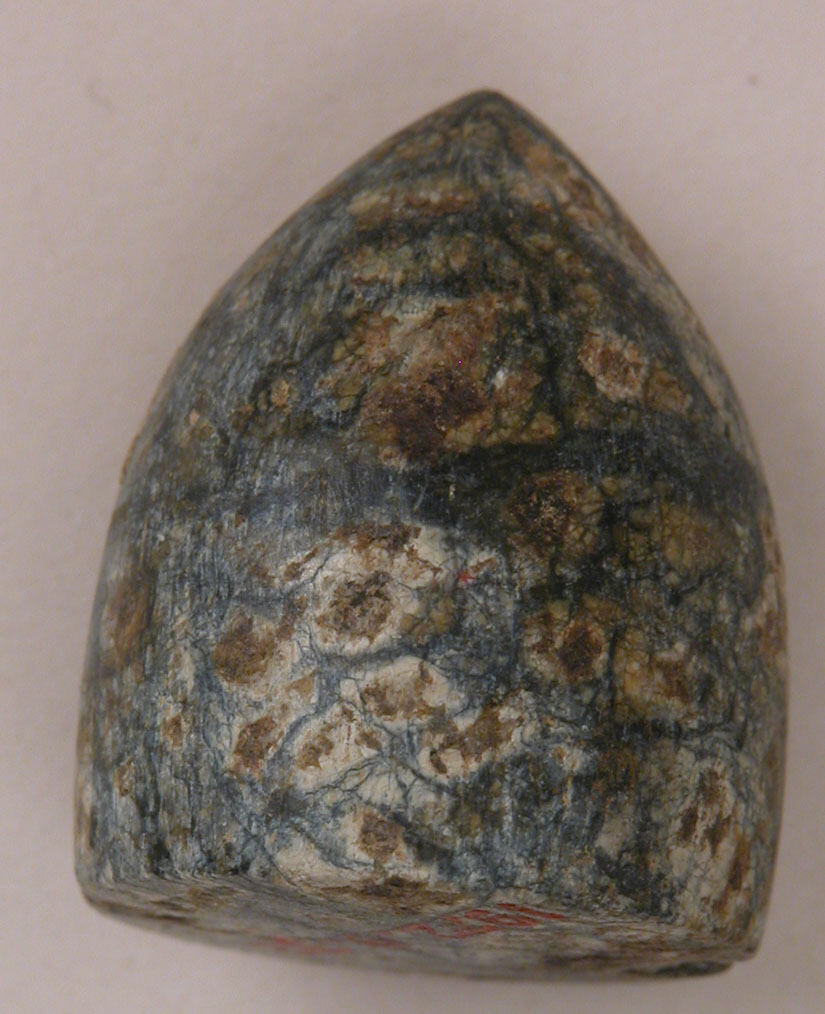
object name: gaming or chess piece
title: Gaming or Chess Piece, Possibly a Pawn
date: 701-1100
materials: stone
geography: western islamic lands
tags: chess